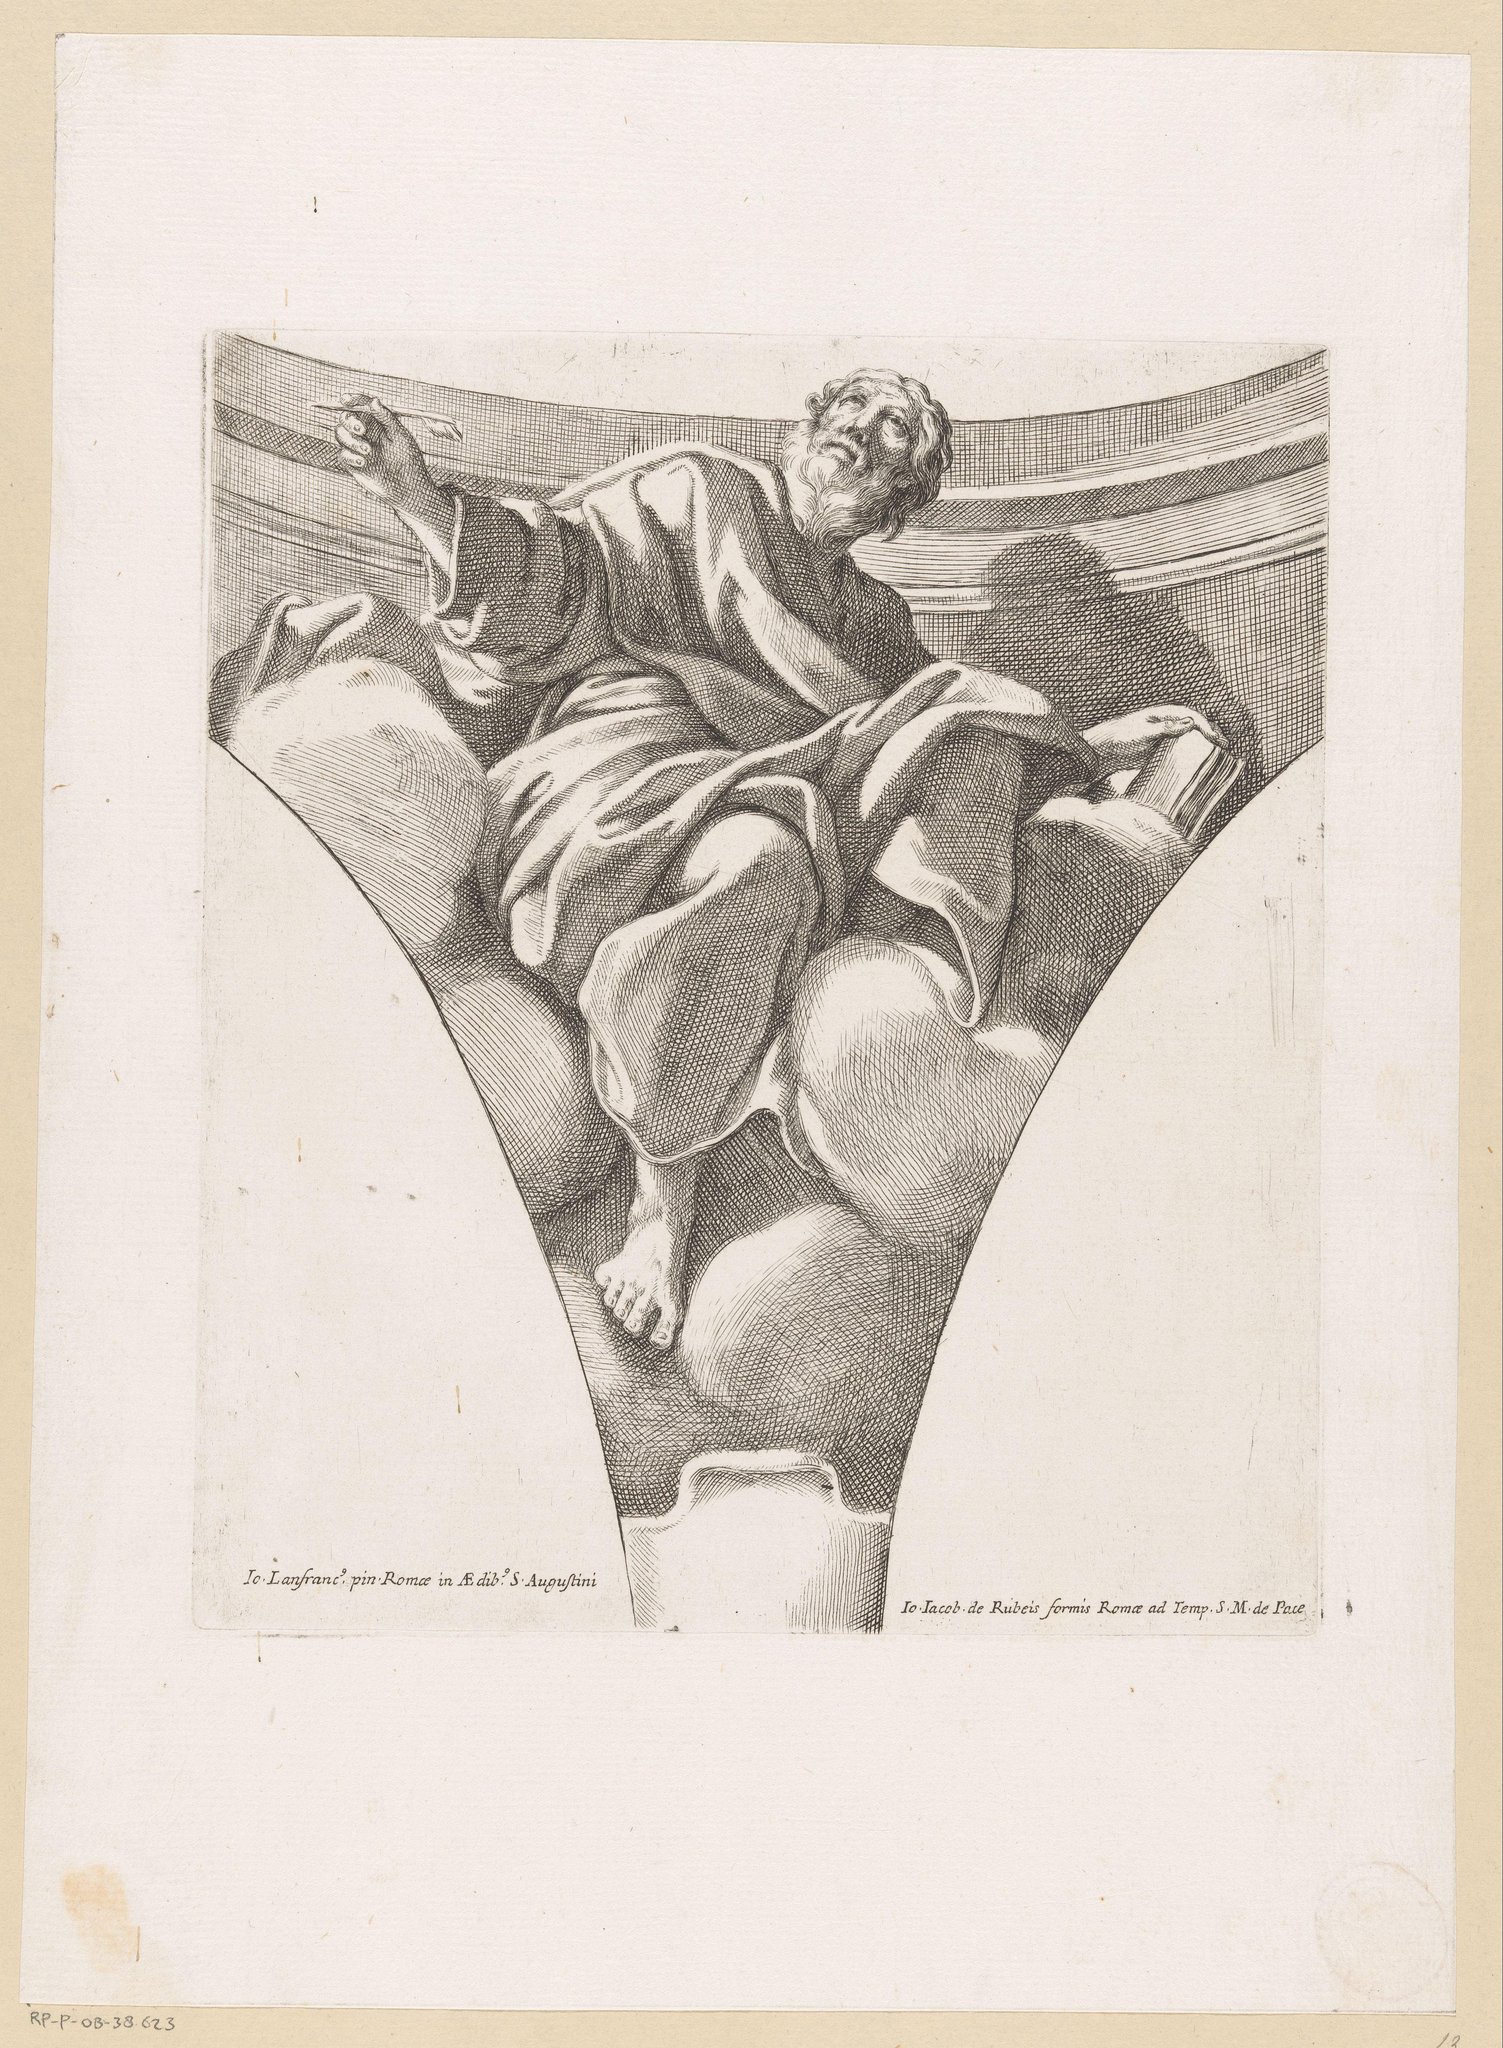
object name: print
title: Schilderingen in de Cappella Buongiovanni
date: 1632-1682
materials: paper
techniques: etching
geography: rome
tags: evangelists, usually with books or scrolls (not in biblical context)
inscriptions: collector's mark: Lugt 240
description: Deze prent maakt deel uit van een serie van negen prenten naar schilderingen door Giovanni Lanfranco in de Cappella Buongiovanni in de Sant'Agostino te Rome.